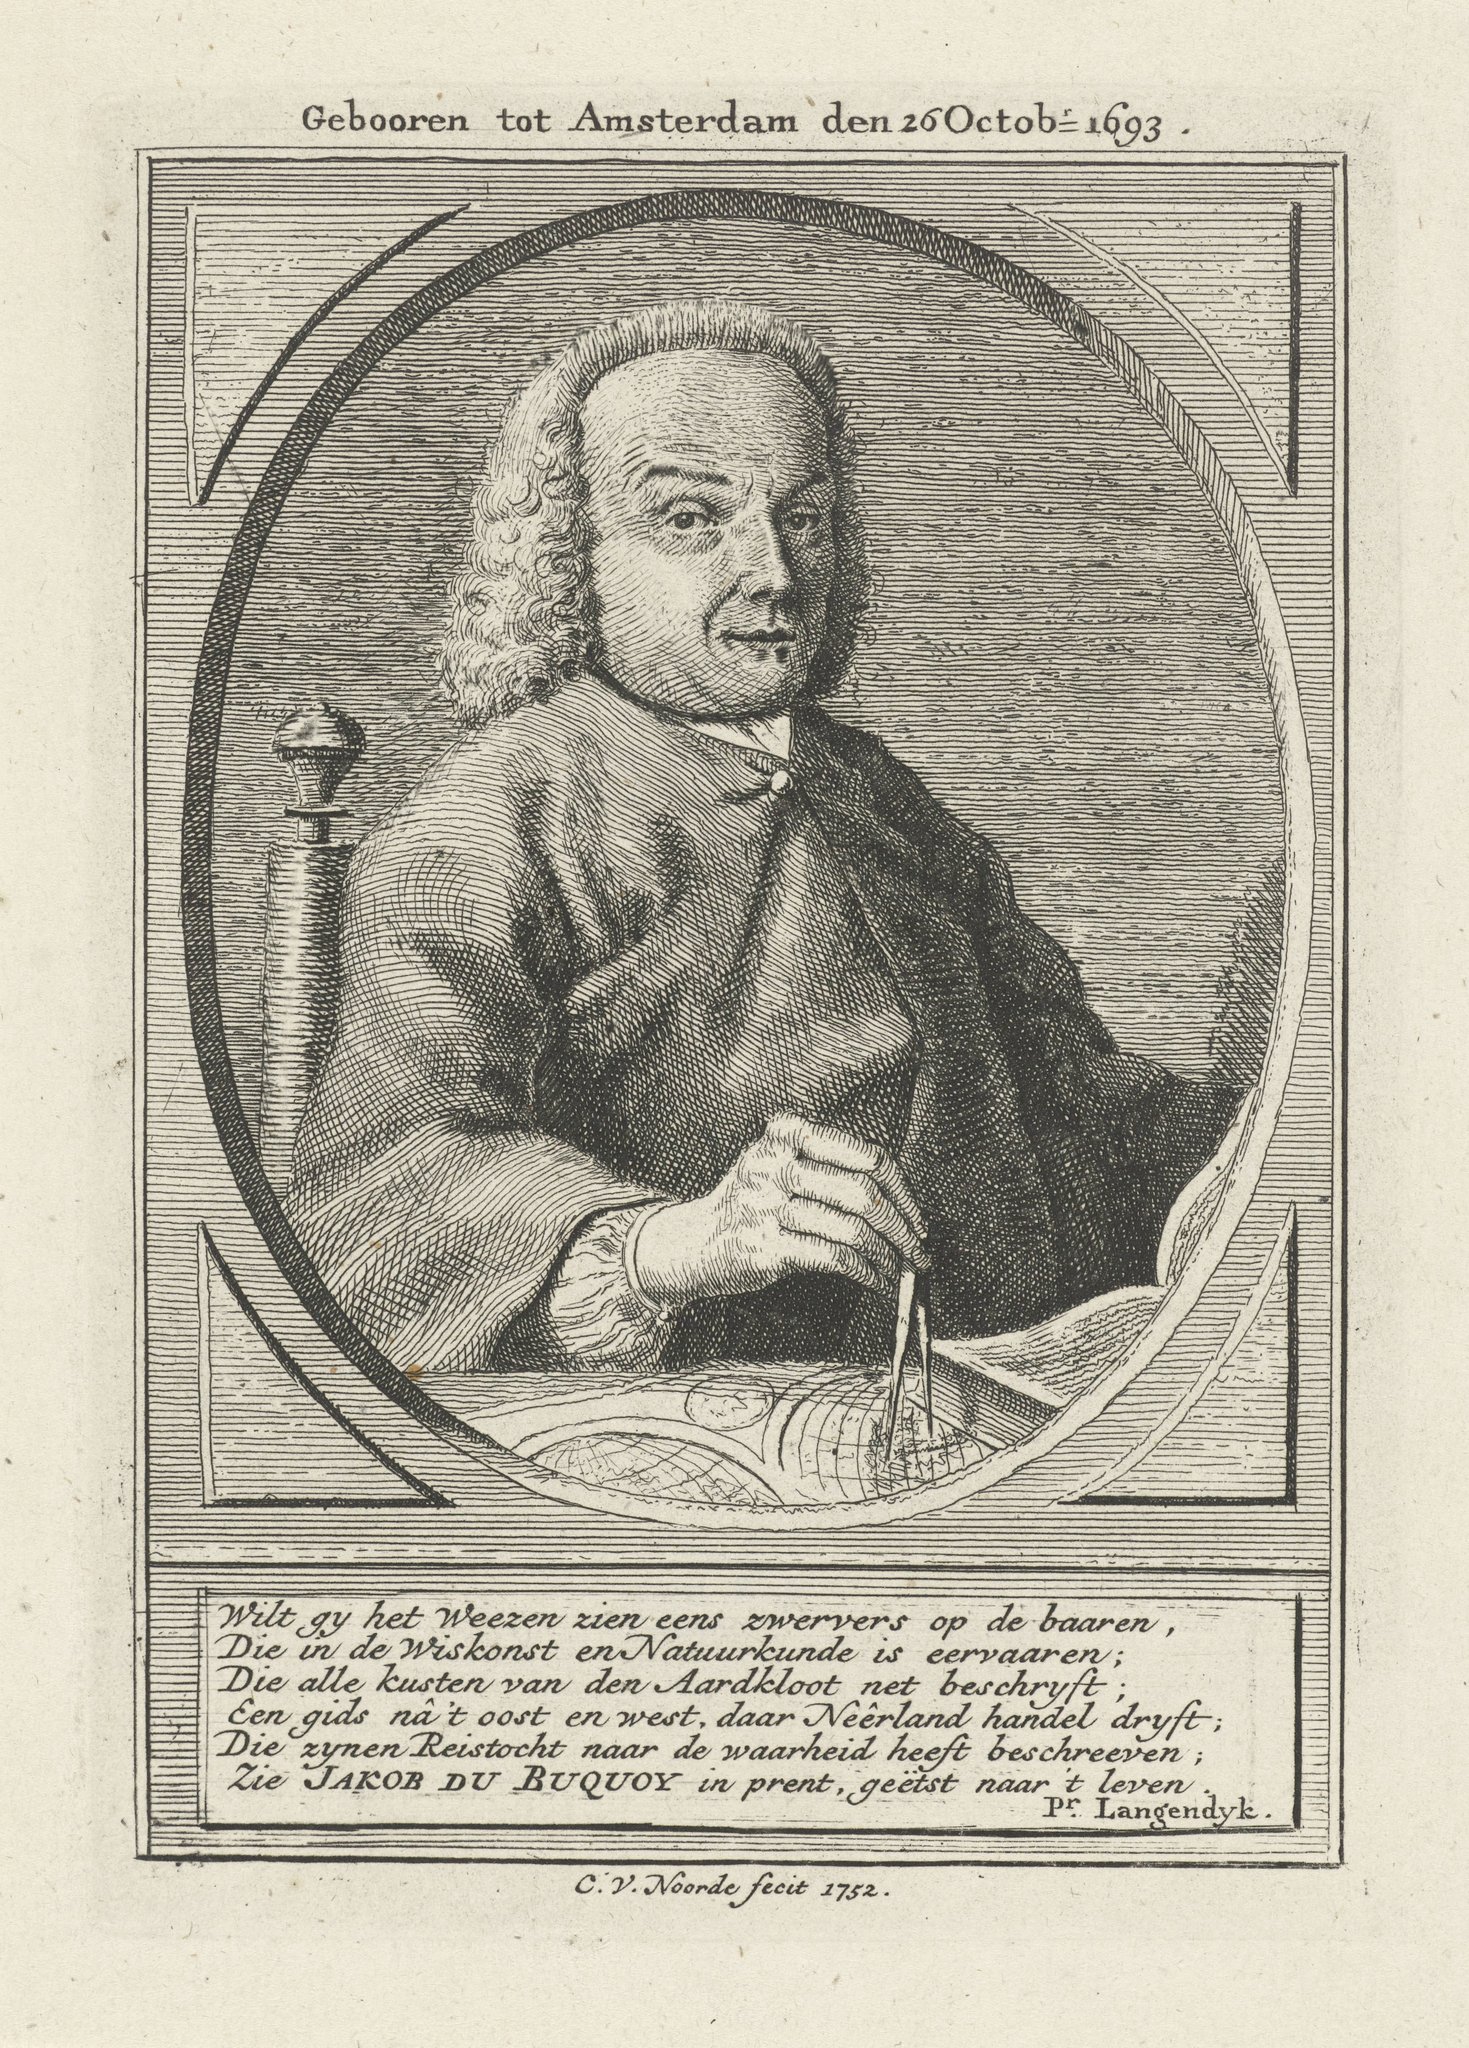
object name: print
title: Portret van Jacob de Bucquoy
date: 1752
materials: paper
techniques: engraving, etching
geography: haarlem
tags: compasses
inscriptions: collector's mark: Lugt 2228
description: Portret van kaartmaker, landmeter en reiziger Jacob de Bucquoy met het boek dat hij over zijn zeereizen schreef. Hij houdt een passer in de hand boven een landkaart.